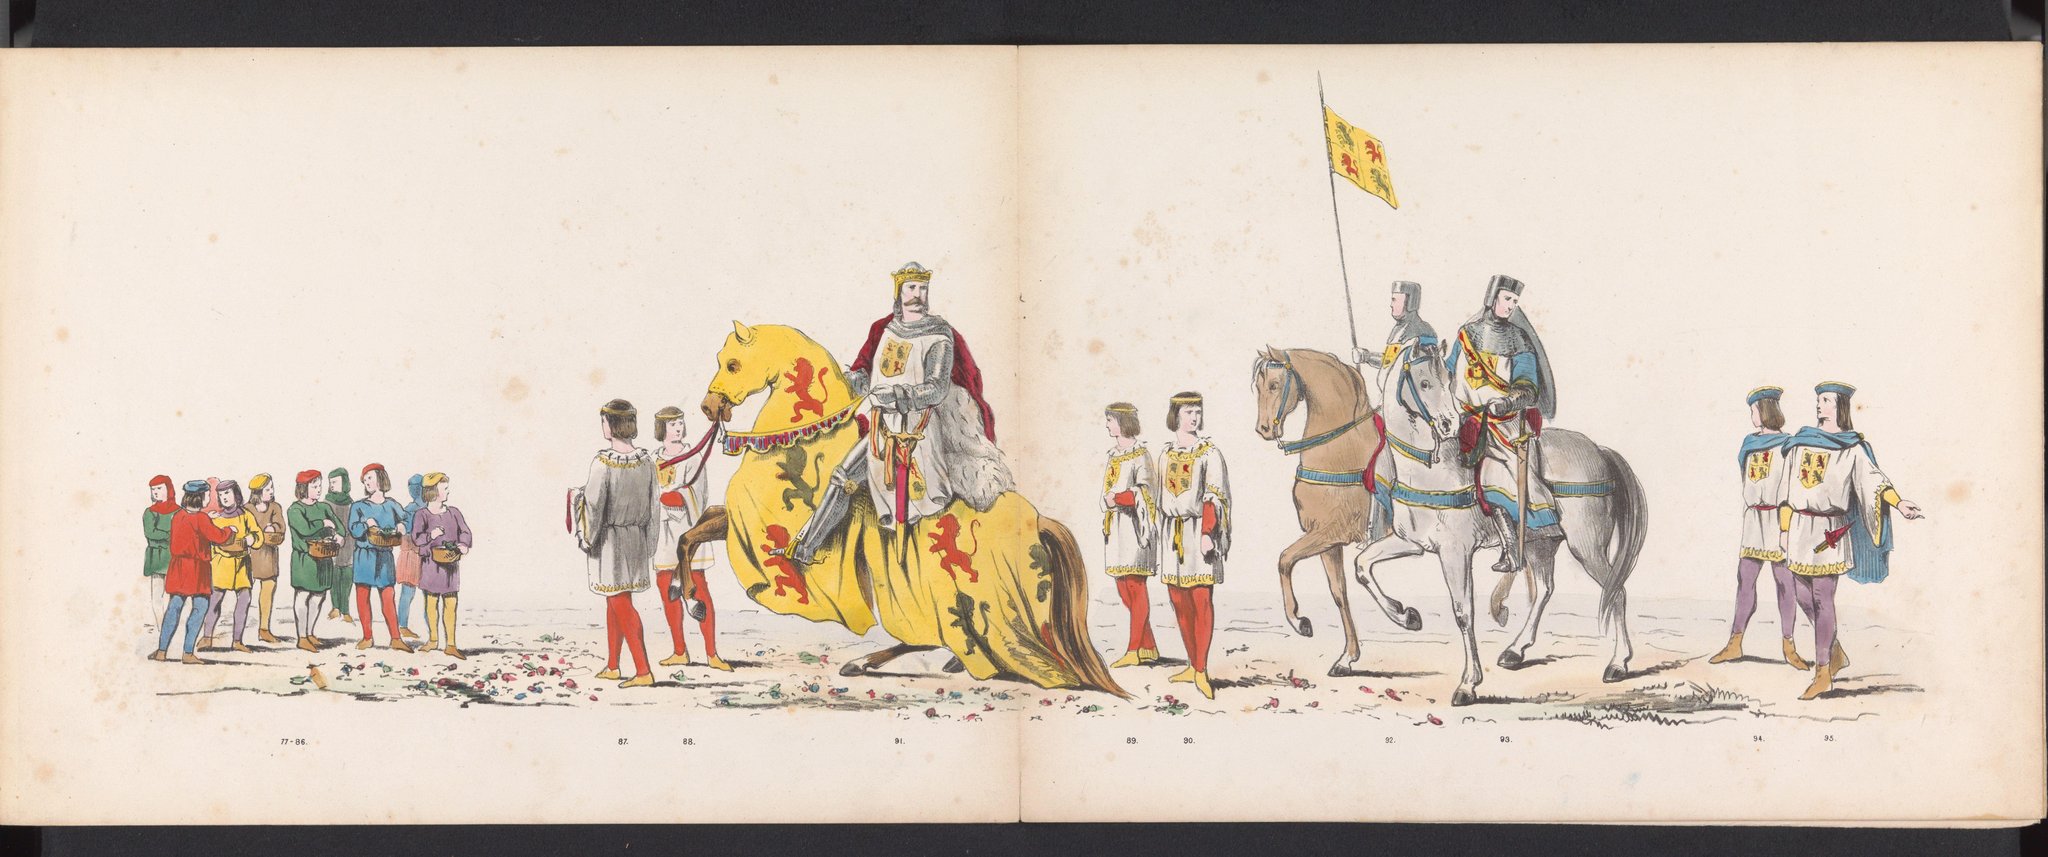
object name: print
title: Gecostumeerde optogt gehouden door de leden van het Leidsche studenten-corps den 6den Junij 1865, ter viering van den 290sten verjaardag der Leidsche Hoogeschool, voorstellende: de intogt der Hollanders binnen Zierikzee onder Jonker Willem, Grave van Oostervant, op den 12den augustus Anno 1304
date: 1865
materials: paper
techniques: hand coloring, lithograph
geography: netherlands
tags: students' pageant, costumes used in pageants, leiden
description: Historische gekostumeerde optocht van de studenten van de Leidse Hogeschool gehouden op 6 juni 1865 ter gelegenheid van het 290-jarig bestaan van de Hogeschool. De optocht verbeeldt de intocht van de Hollanders binnen Zierikzee op 12 augustus 1304. Zevende plaat met de groepen genummerd 77-95. Onderdeel van de serie van 16 aaneen geplakte bladen.